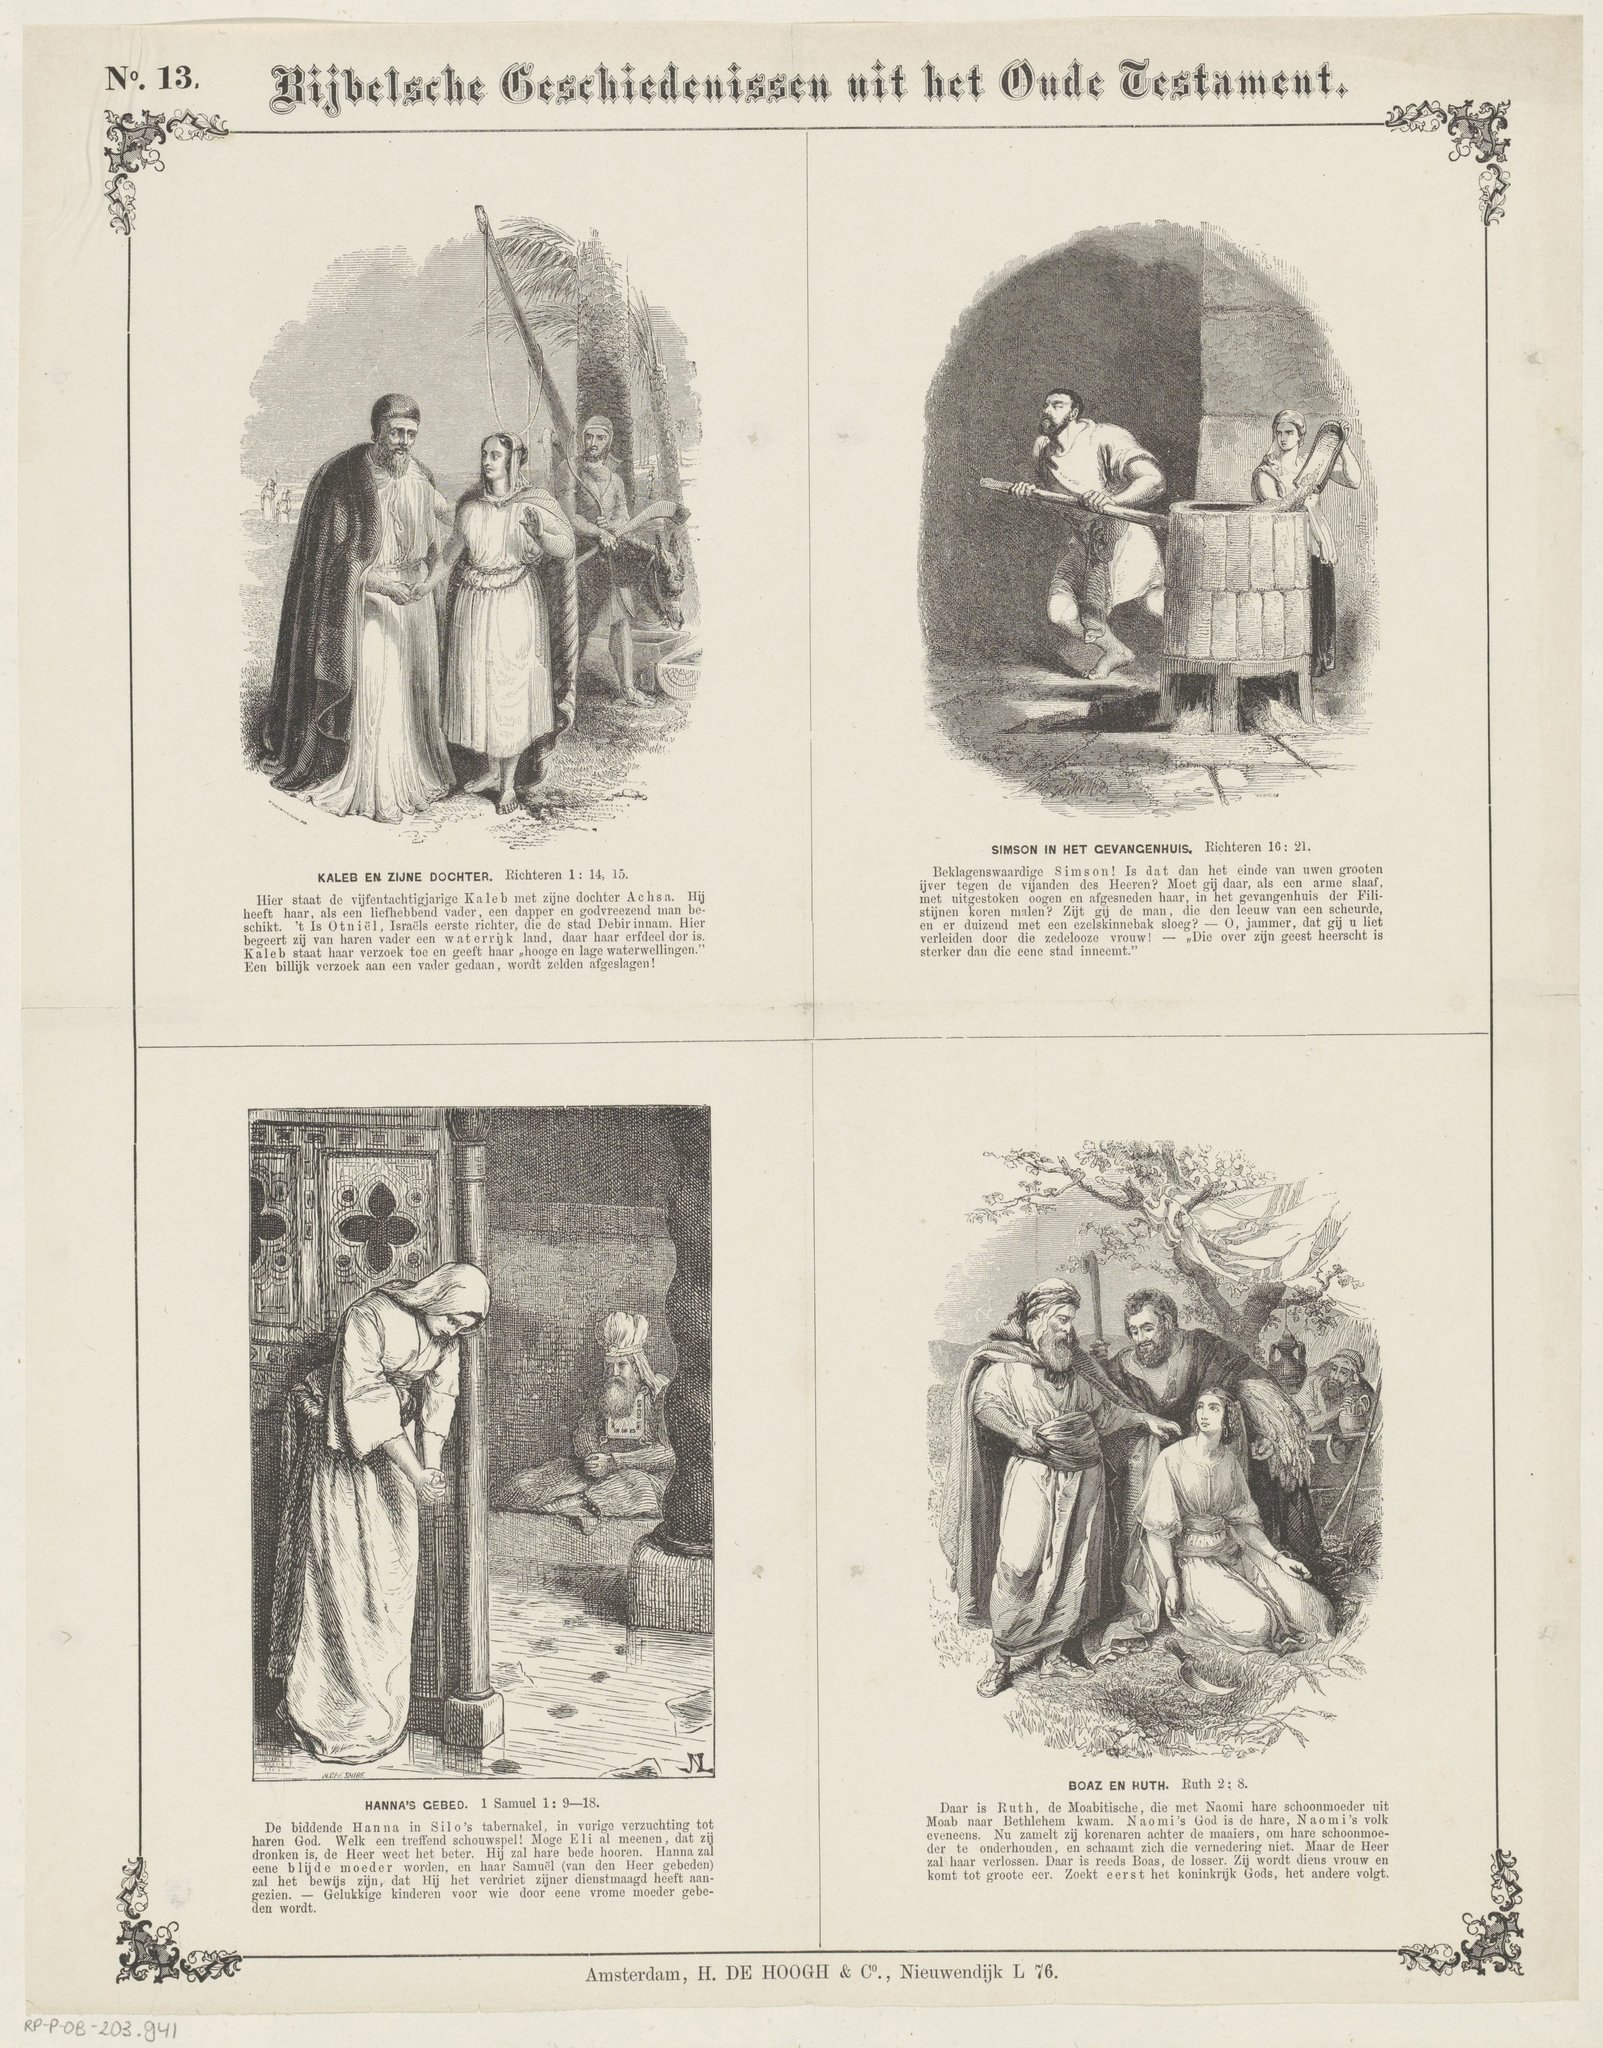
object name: popular print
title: Bijbelsche geschiedenissen uit het Oude Testament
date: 1866-1871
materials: paper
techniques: letterpress printing, engraving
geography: amsterdam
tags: samson grinding in prison (in a treadmill), ruth and naomi in bethlehem (ruth 2:1-2), hannah's prayer and song of thankfulness, old testament, othniel conquers debir, and receives caleb's daughter achsah to wife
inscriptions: collector's mark: Lugt 2760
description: Blad met 4 voorstellingen van verhalen uit het Oude Testament. Kaleb en zijn dochter, Simson in de gevangenis, Hanna's gebed en Boaz en Ruth. Onder elke afbeelding de bijbehorende Bijbeltekst. Genummerd linksboven: No. 13.